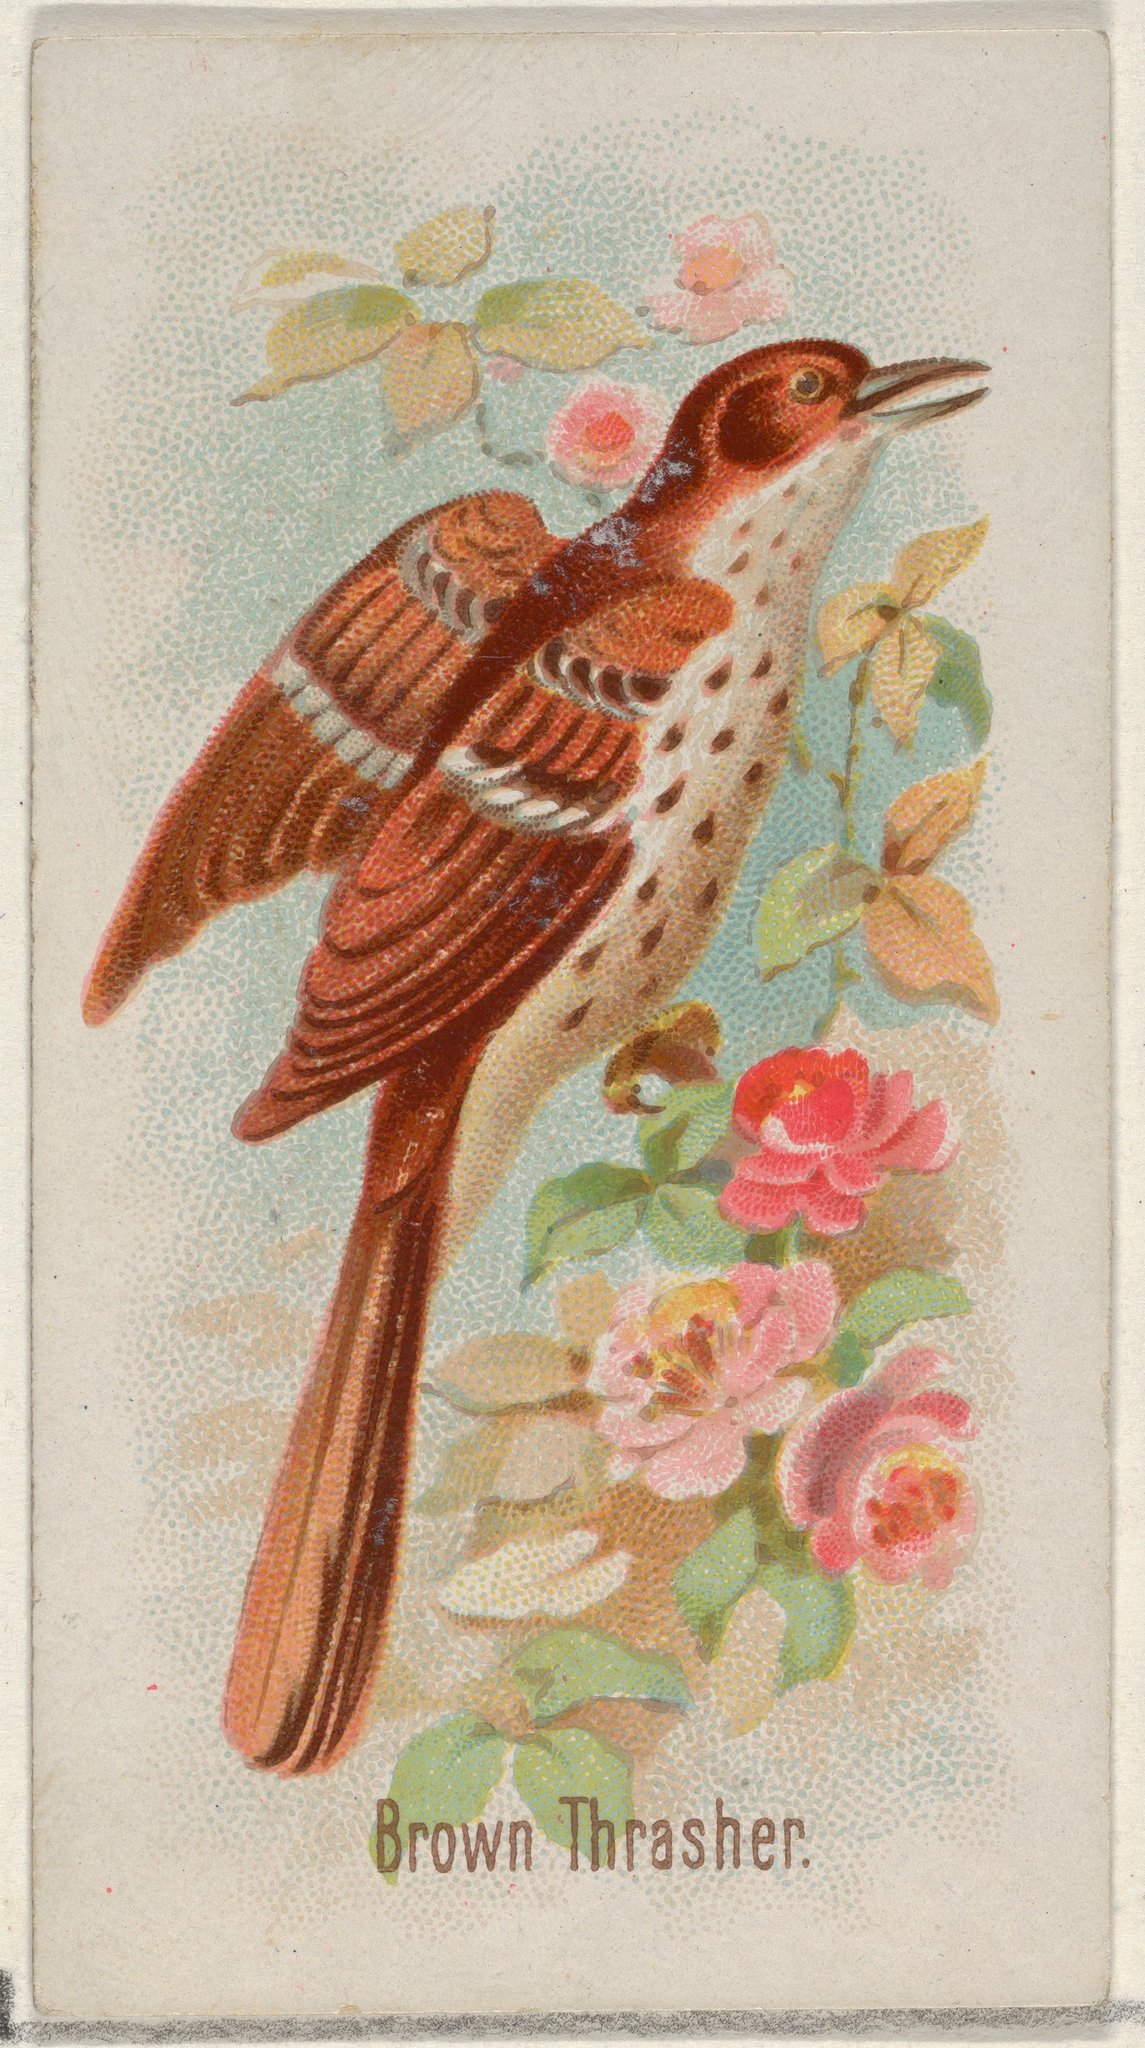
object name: print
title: Brown Thrasher, from the Song Birds of the World series (N23) for Allen & Ginter Cigarettes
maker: allen & ginter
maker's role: publisher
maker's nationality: american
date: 1890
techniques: color lithograph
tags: birds